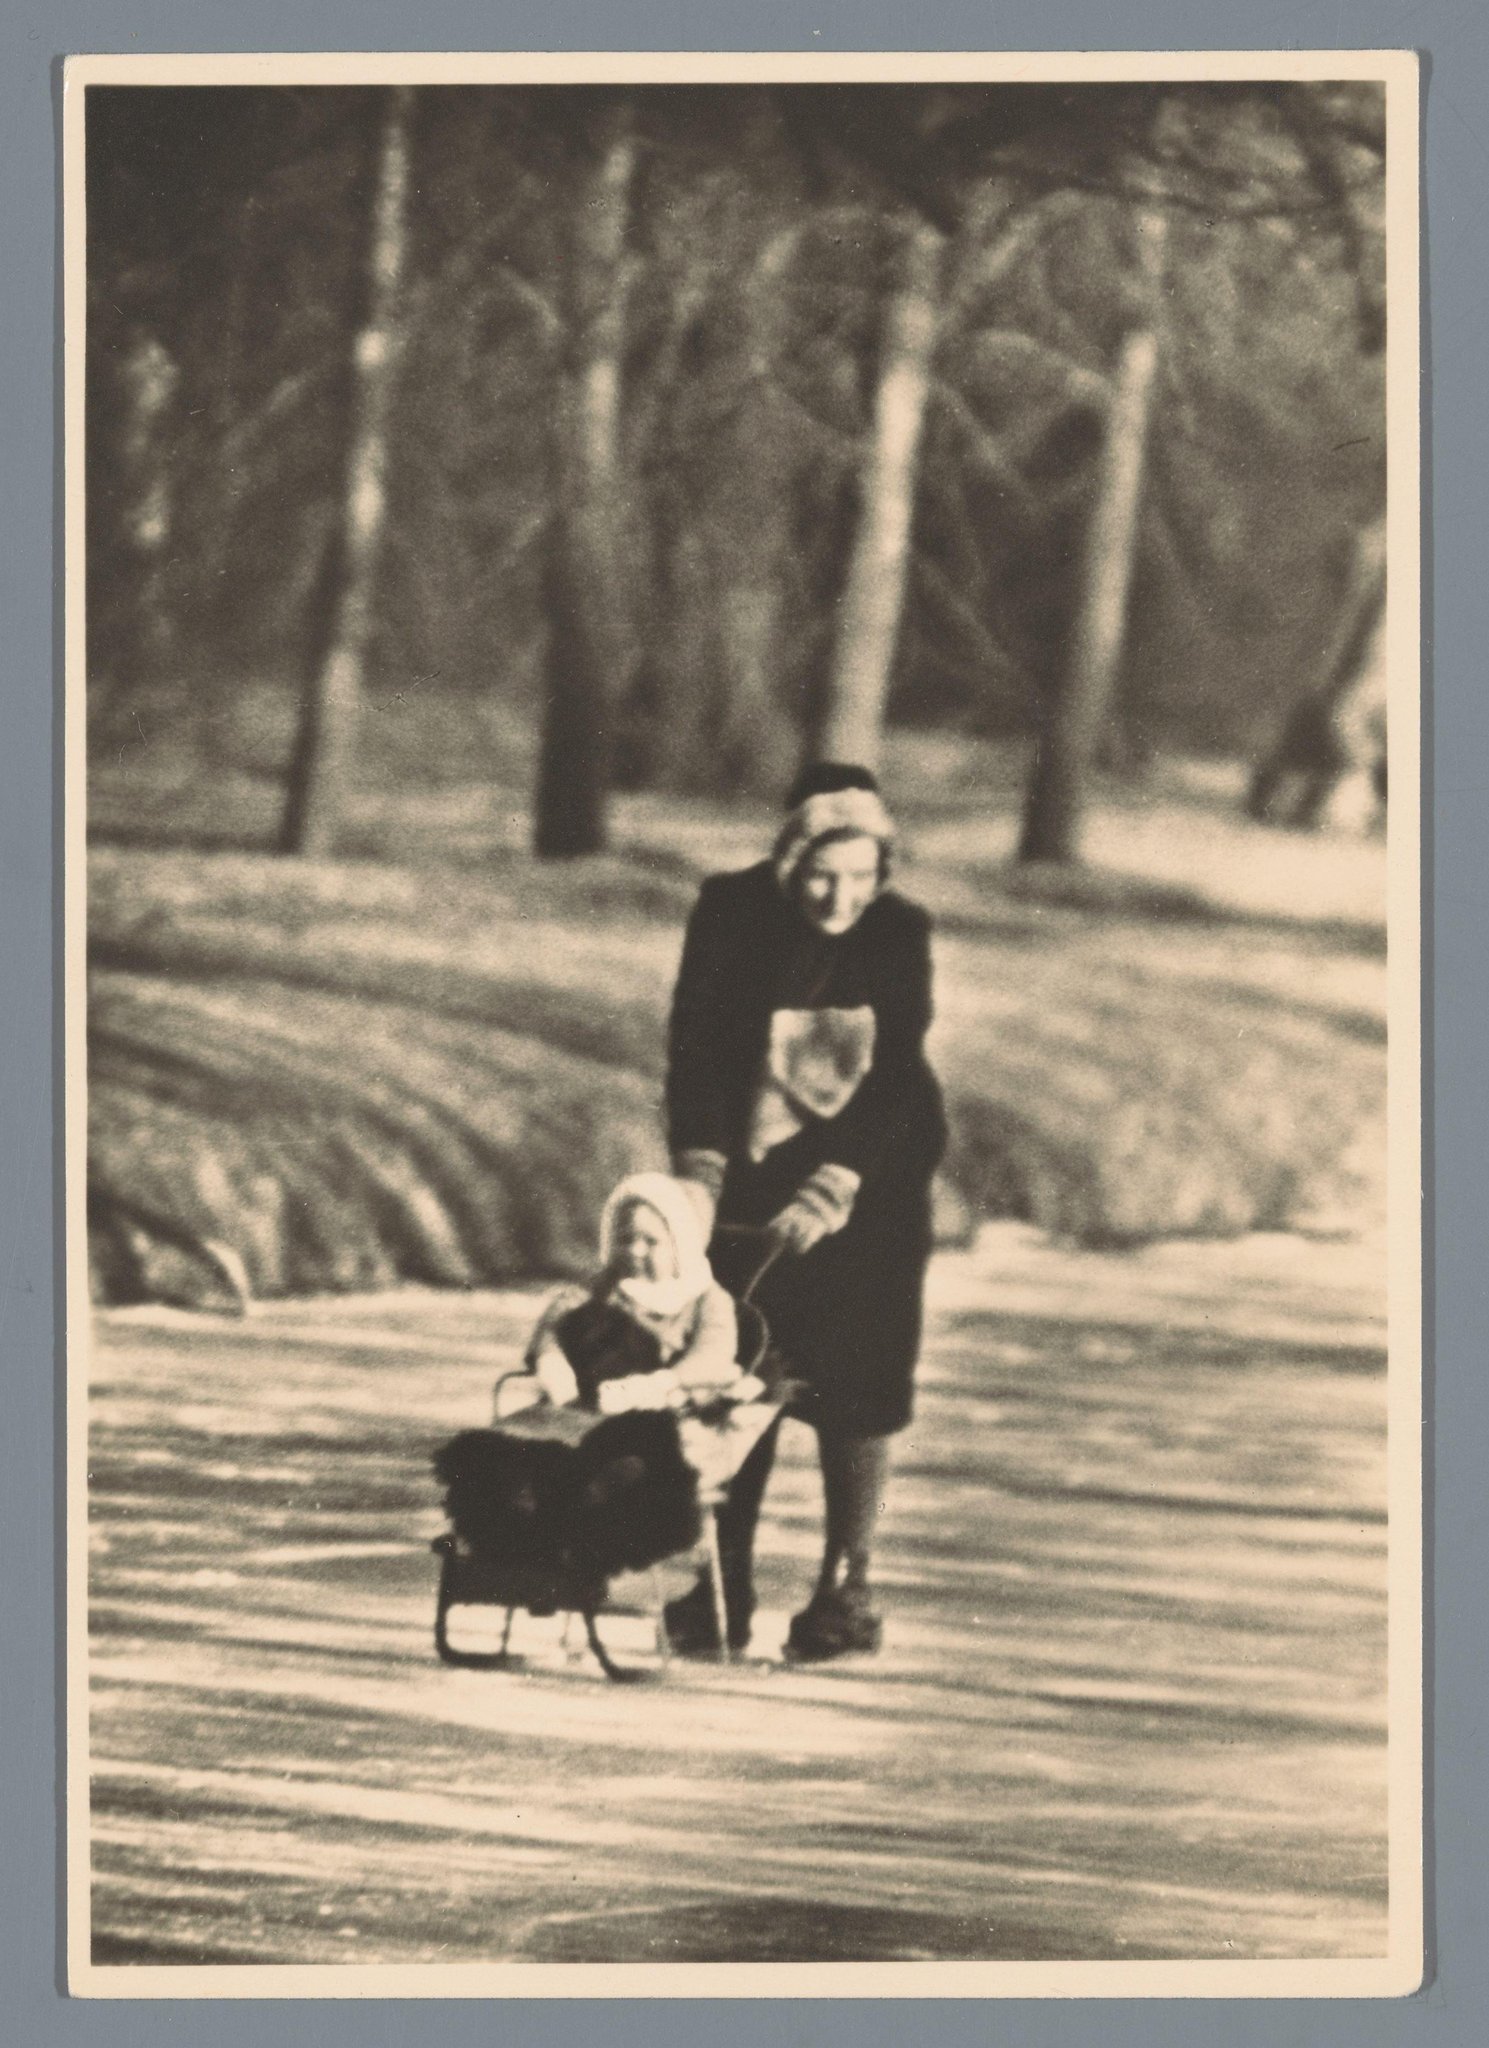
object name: photograph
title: Op de vijvers van het Huis ten Bosch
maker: Anonymous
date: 1940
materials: photographic support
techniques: gelatin silver print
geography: the hague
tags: beatrix (koningin der nederlanden), juliana of the netherlands, crown princess, sleigh, sledge (non-sport), princess, mother and daughter(s) (family group)